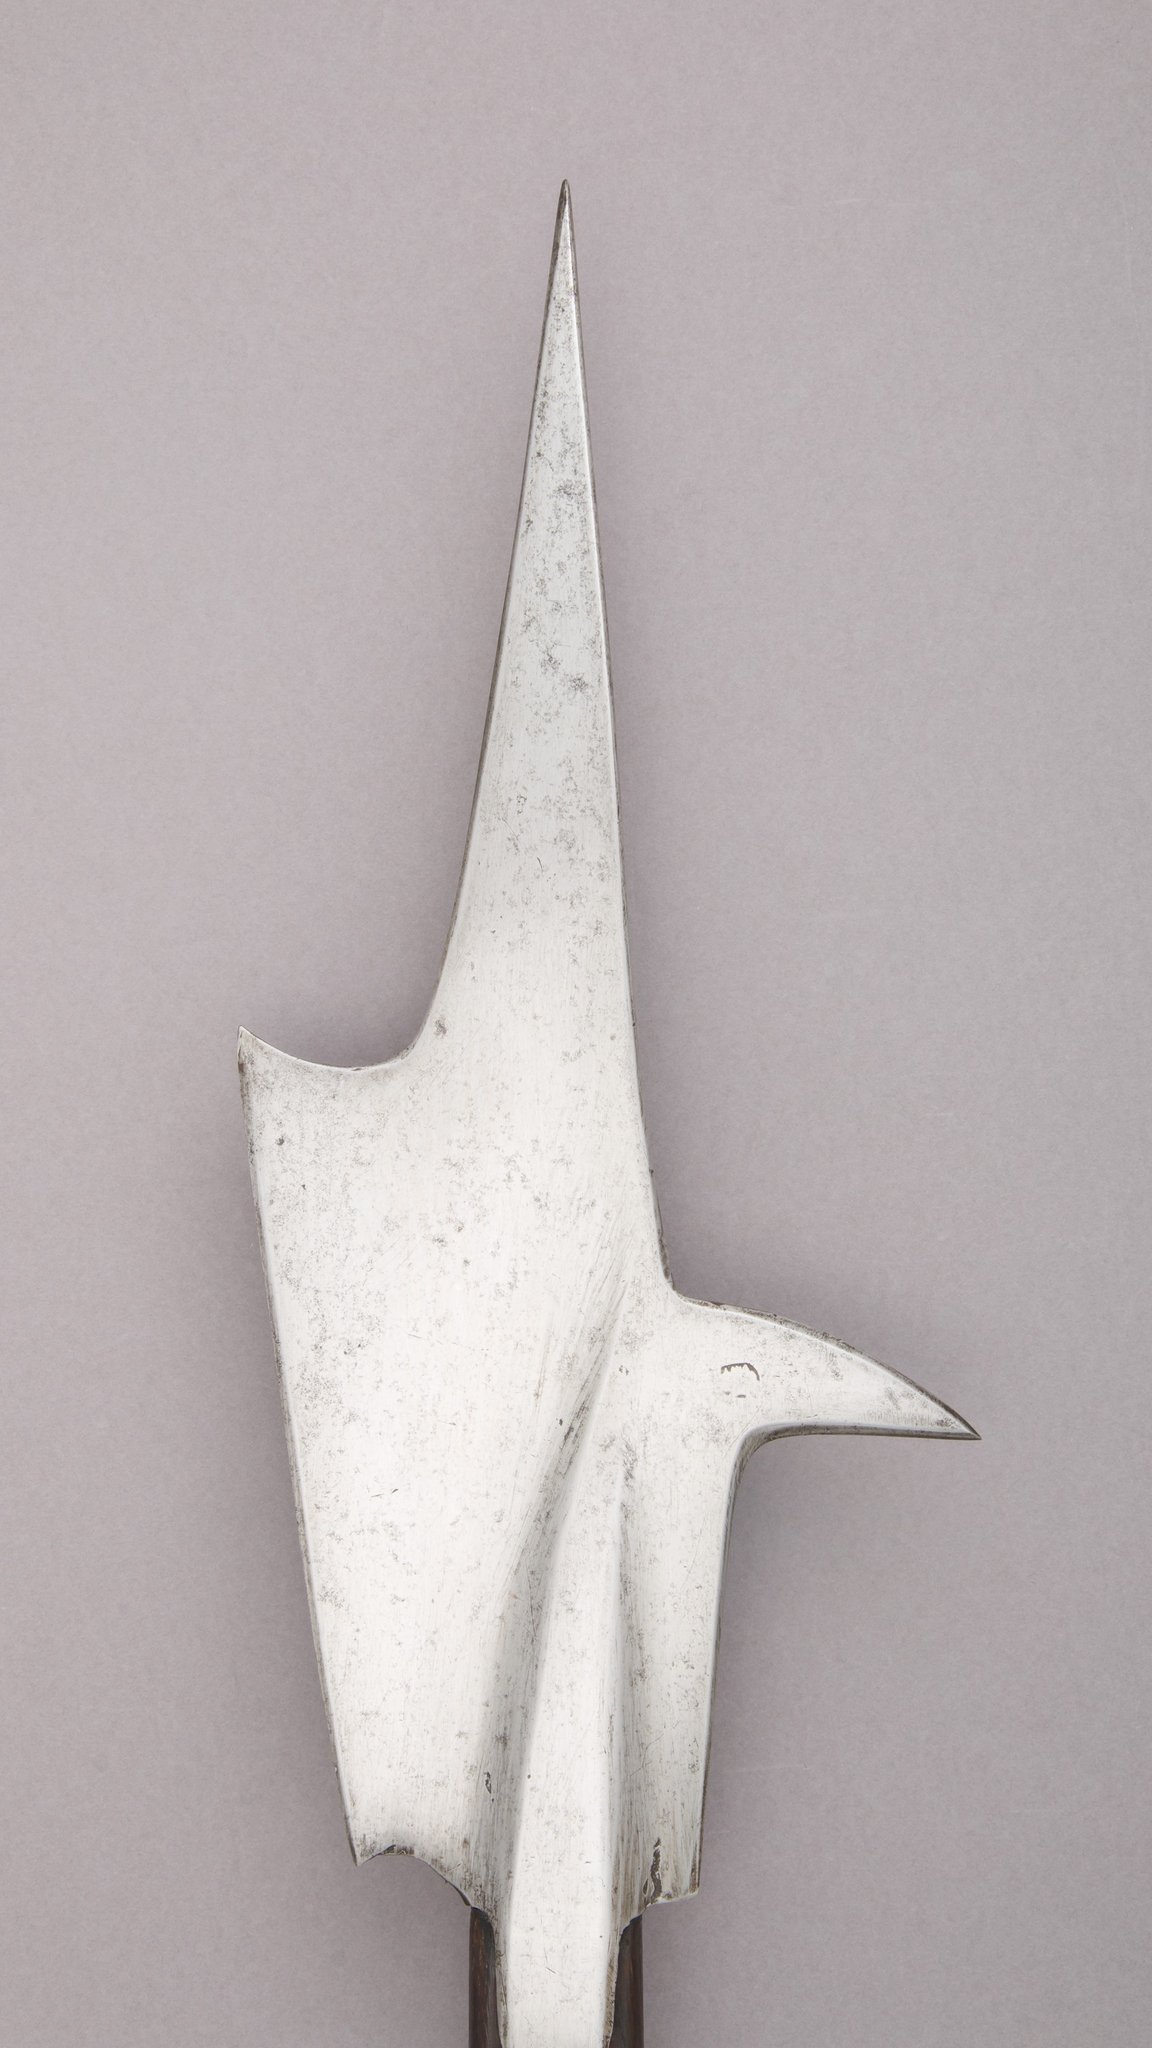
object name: halberd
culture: german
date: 1401-1500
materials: steel, wood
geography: germany